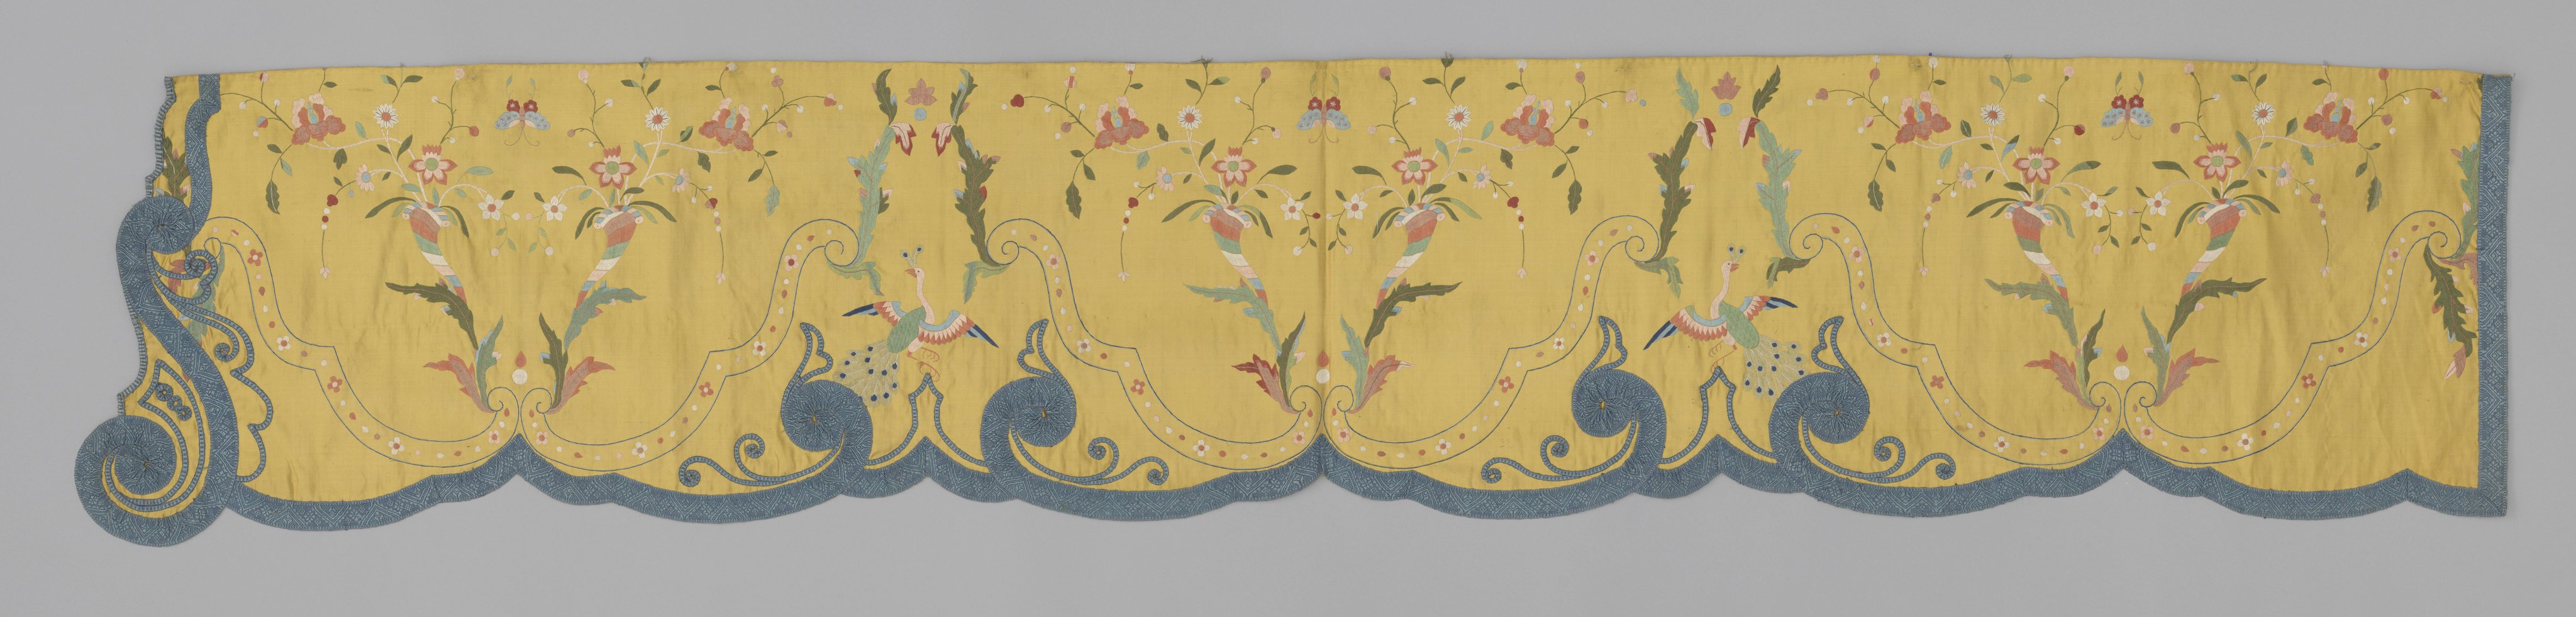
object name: lambrequin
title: Lambrekijn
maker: Anonymous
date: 1720-1740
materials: linen, silk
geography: guangdong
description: Geel zijden lambrekijn van een bedgarnituur geborduurd met pauwen, bloemen, vlinders, hoorns van overvloed in veelkleurige zijde, omboord en versierd met blauw passement, gevoerd met grof linnen en gele zijde. Bestemd voor de rechterkant van het bed, buitenkant.